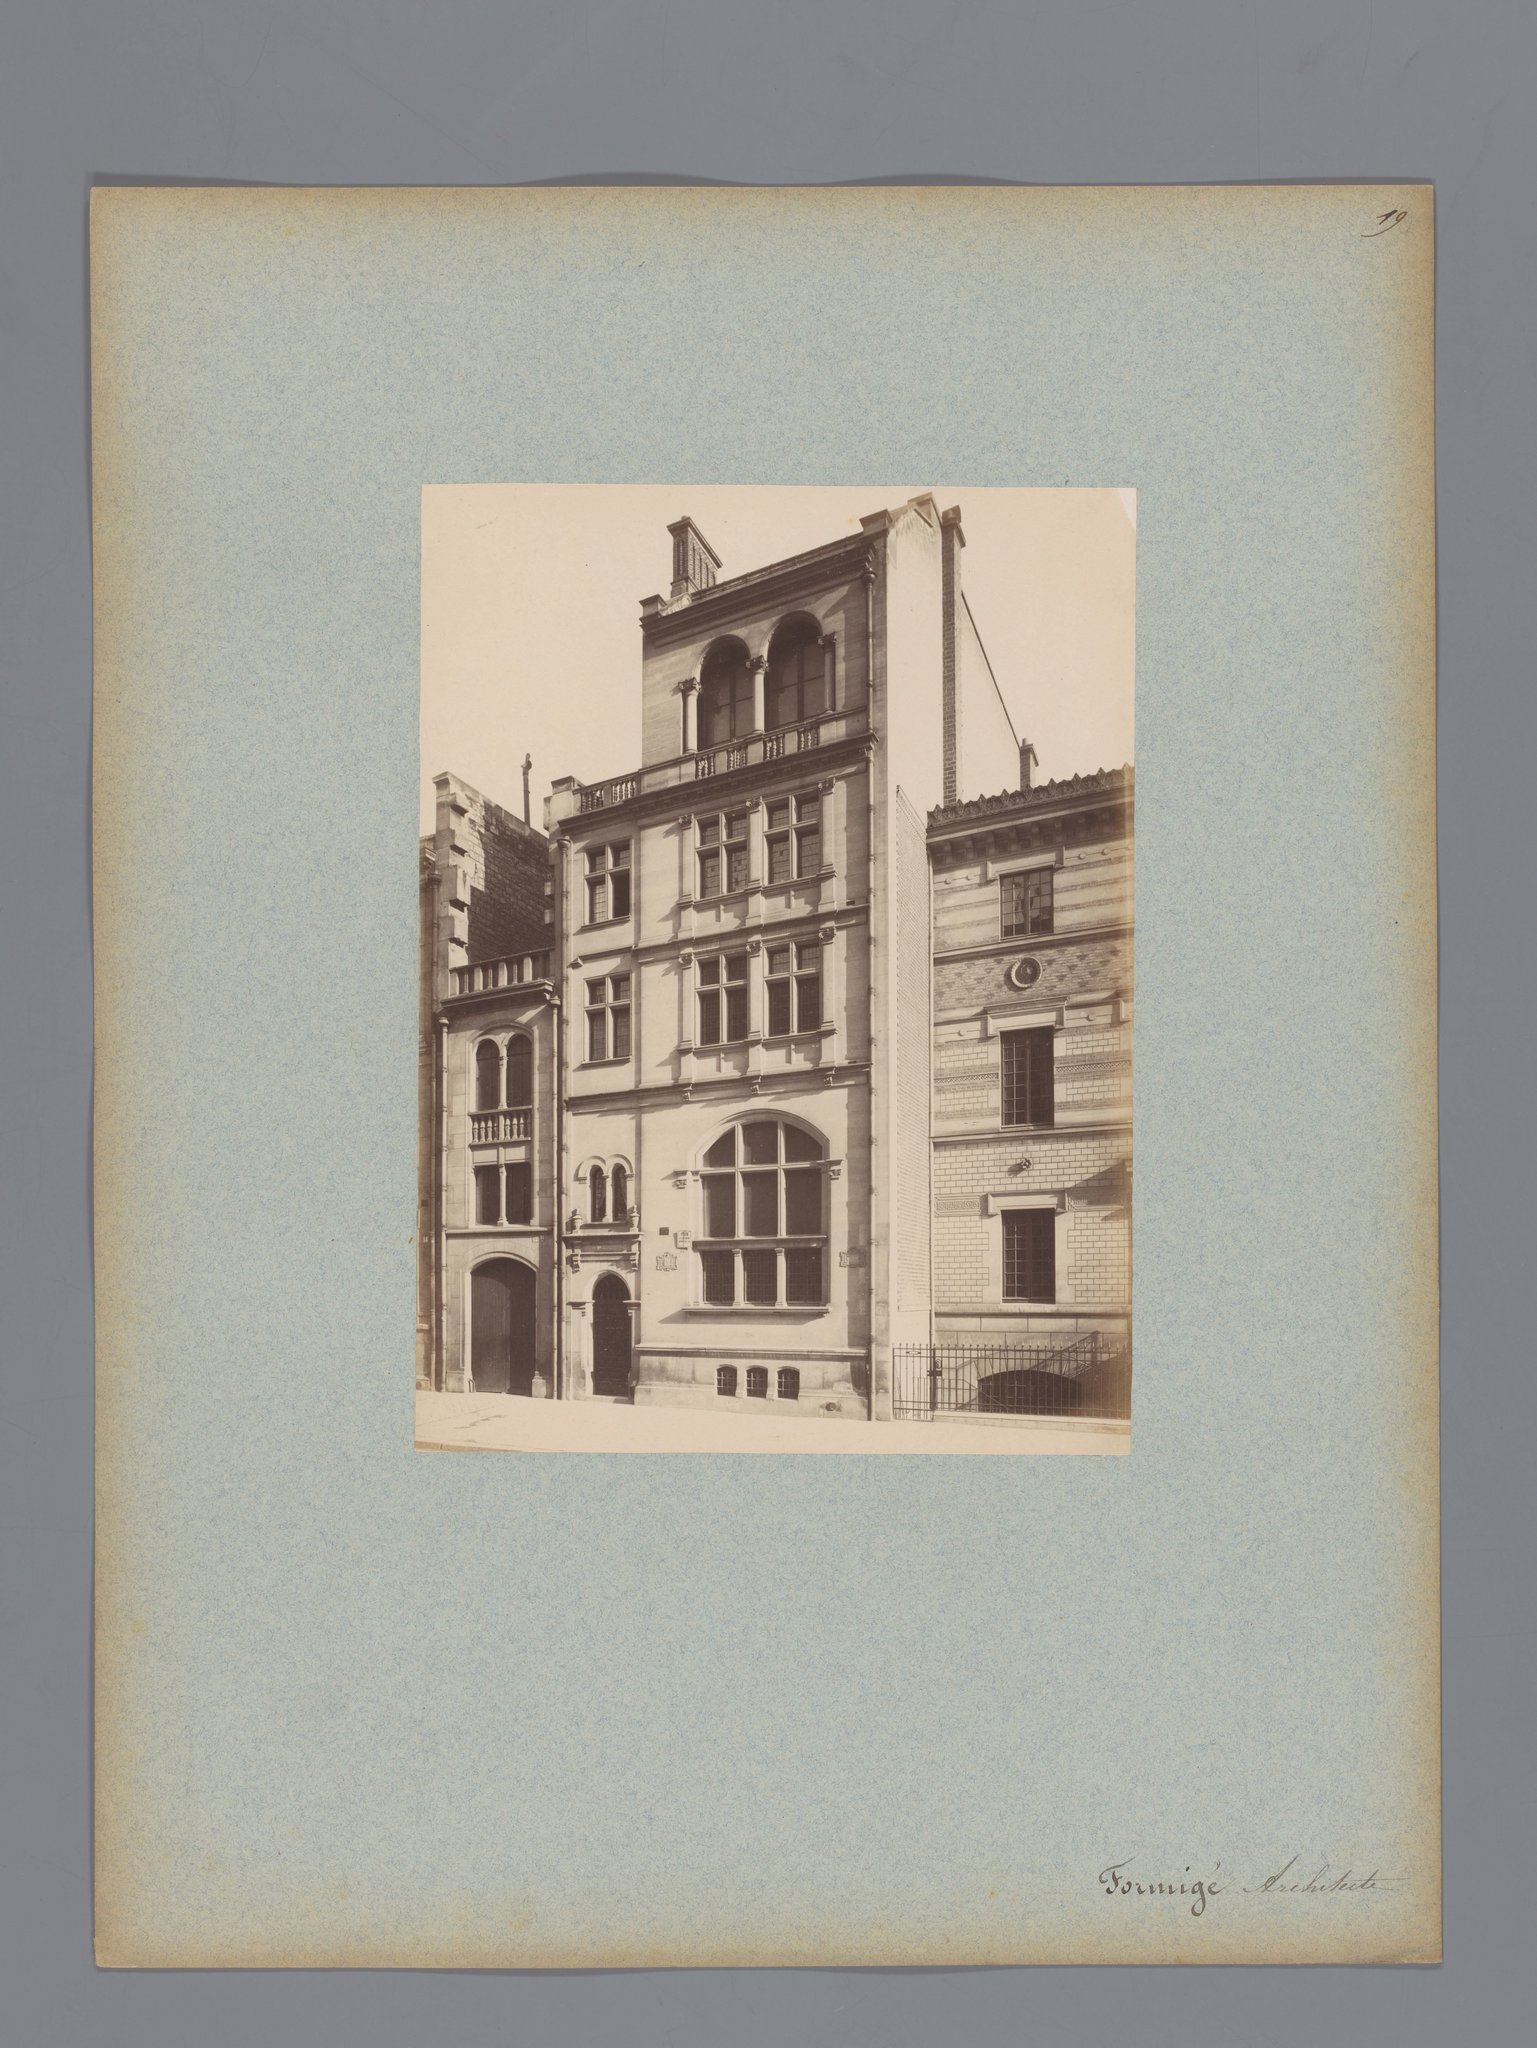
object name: photograph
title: Façade van een gebouw in Parijs, ontworpen door Jean Camille Formigé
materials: photographic support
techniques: albumen print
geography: paris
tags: urban housing, façade (of house or building), paris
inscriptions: number: ‘19’, name: ‘Formigé Architecte’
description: Deze foto maakt deel uit van een omslag met 35 foto's en een titelblad.